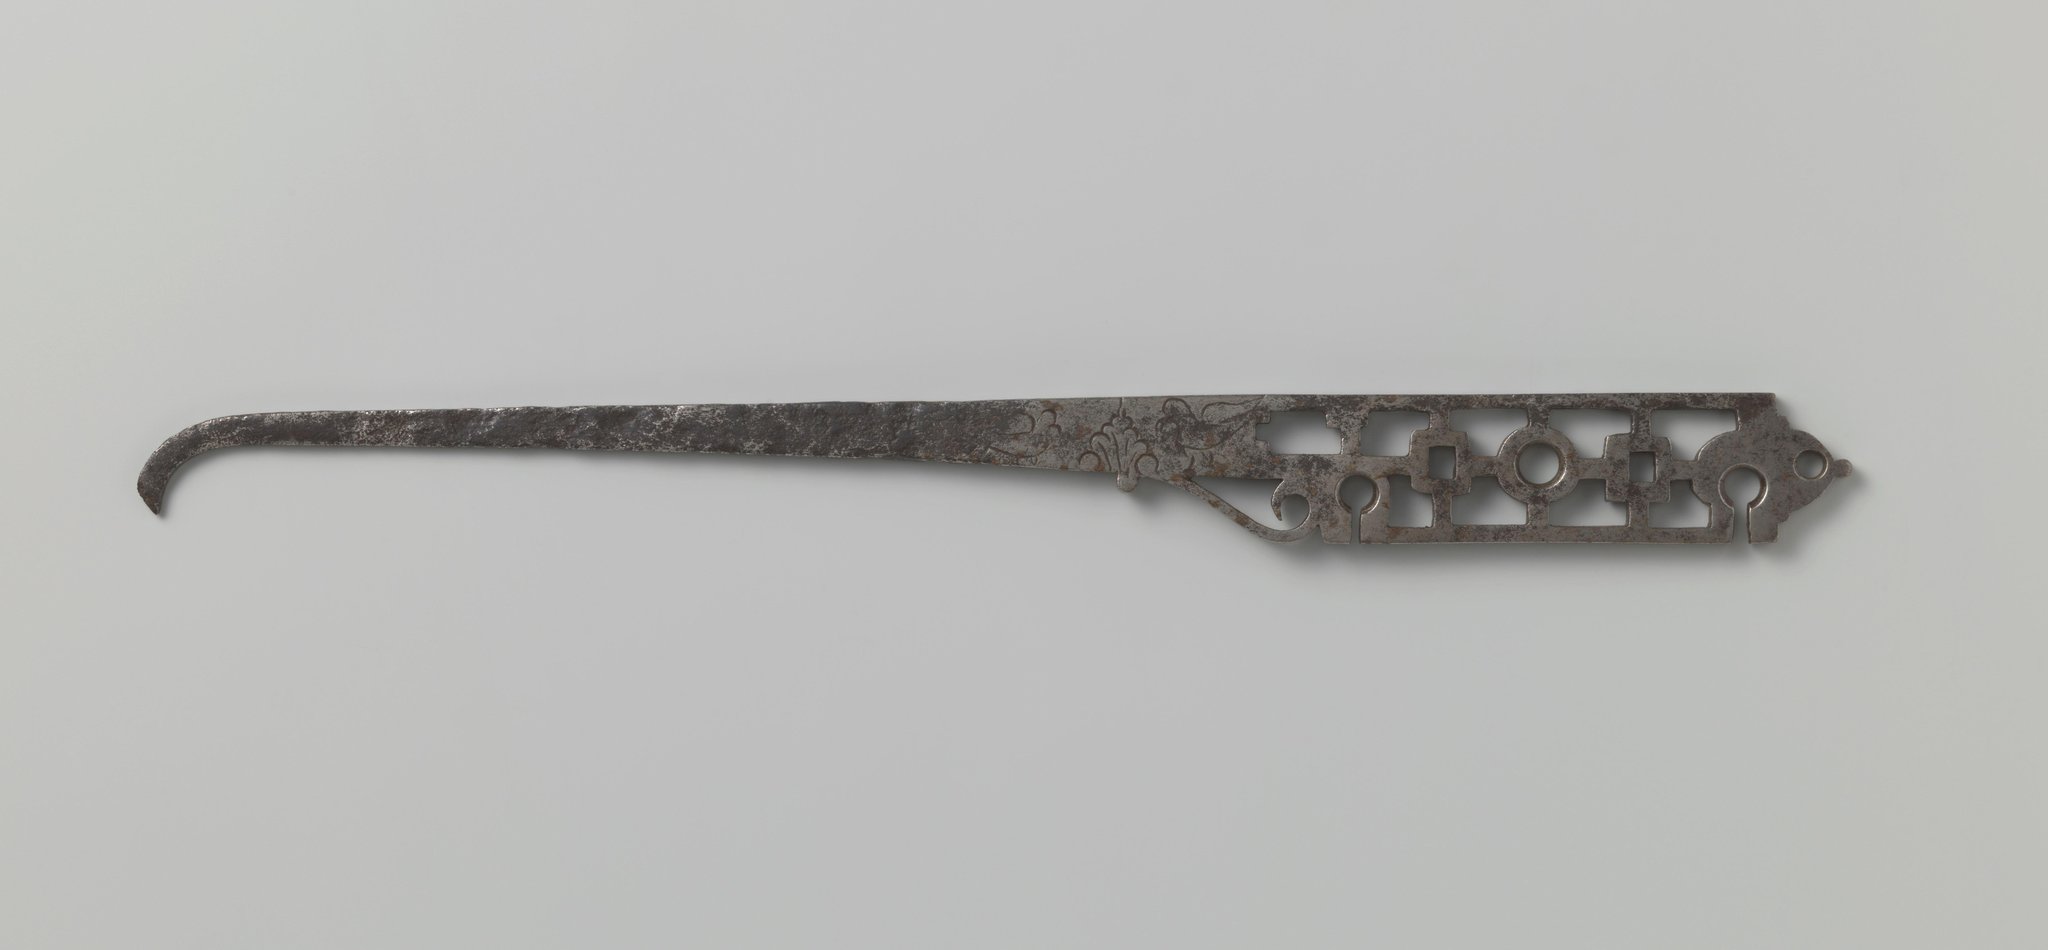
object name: fragment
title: Onderdeel van een werktuig, gedecoreerd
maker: Anonymous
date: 1600-1699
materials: iron, tin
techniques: engraving, forging, tinning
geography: low countries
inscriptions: quality mark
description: Onderdeel van een werktuig van vertind ijzer, vermoedelijk van een haal. Het brede deel is opengewerkt met geometrische vlakken en twee cirkels, die aan een zijde open zijn om iets aan te hangen. Dit brede deel loopt naar het einde smaller toe tot een slanke, platte pin, die aan het uiteinde omkrult.